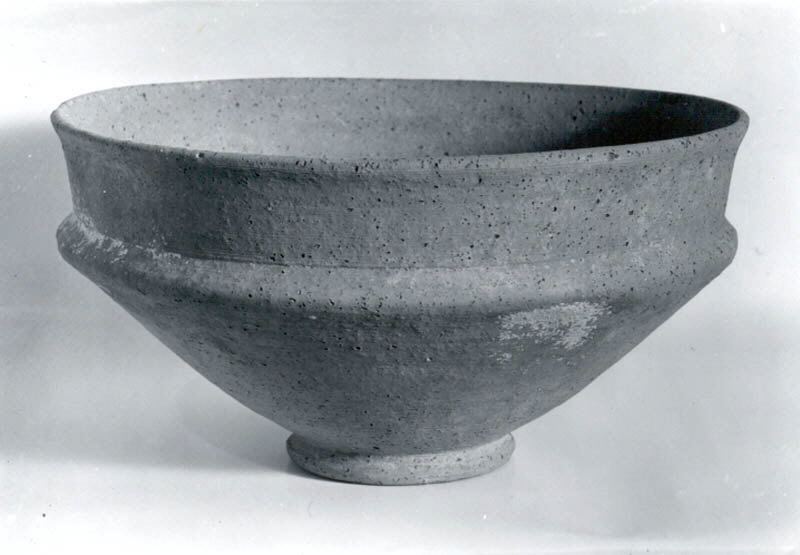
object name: bowl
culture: canaanite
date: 1780-1580 BCE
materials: ceramic, paint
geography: levant